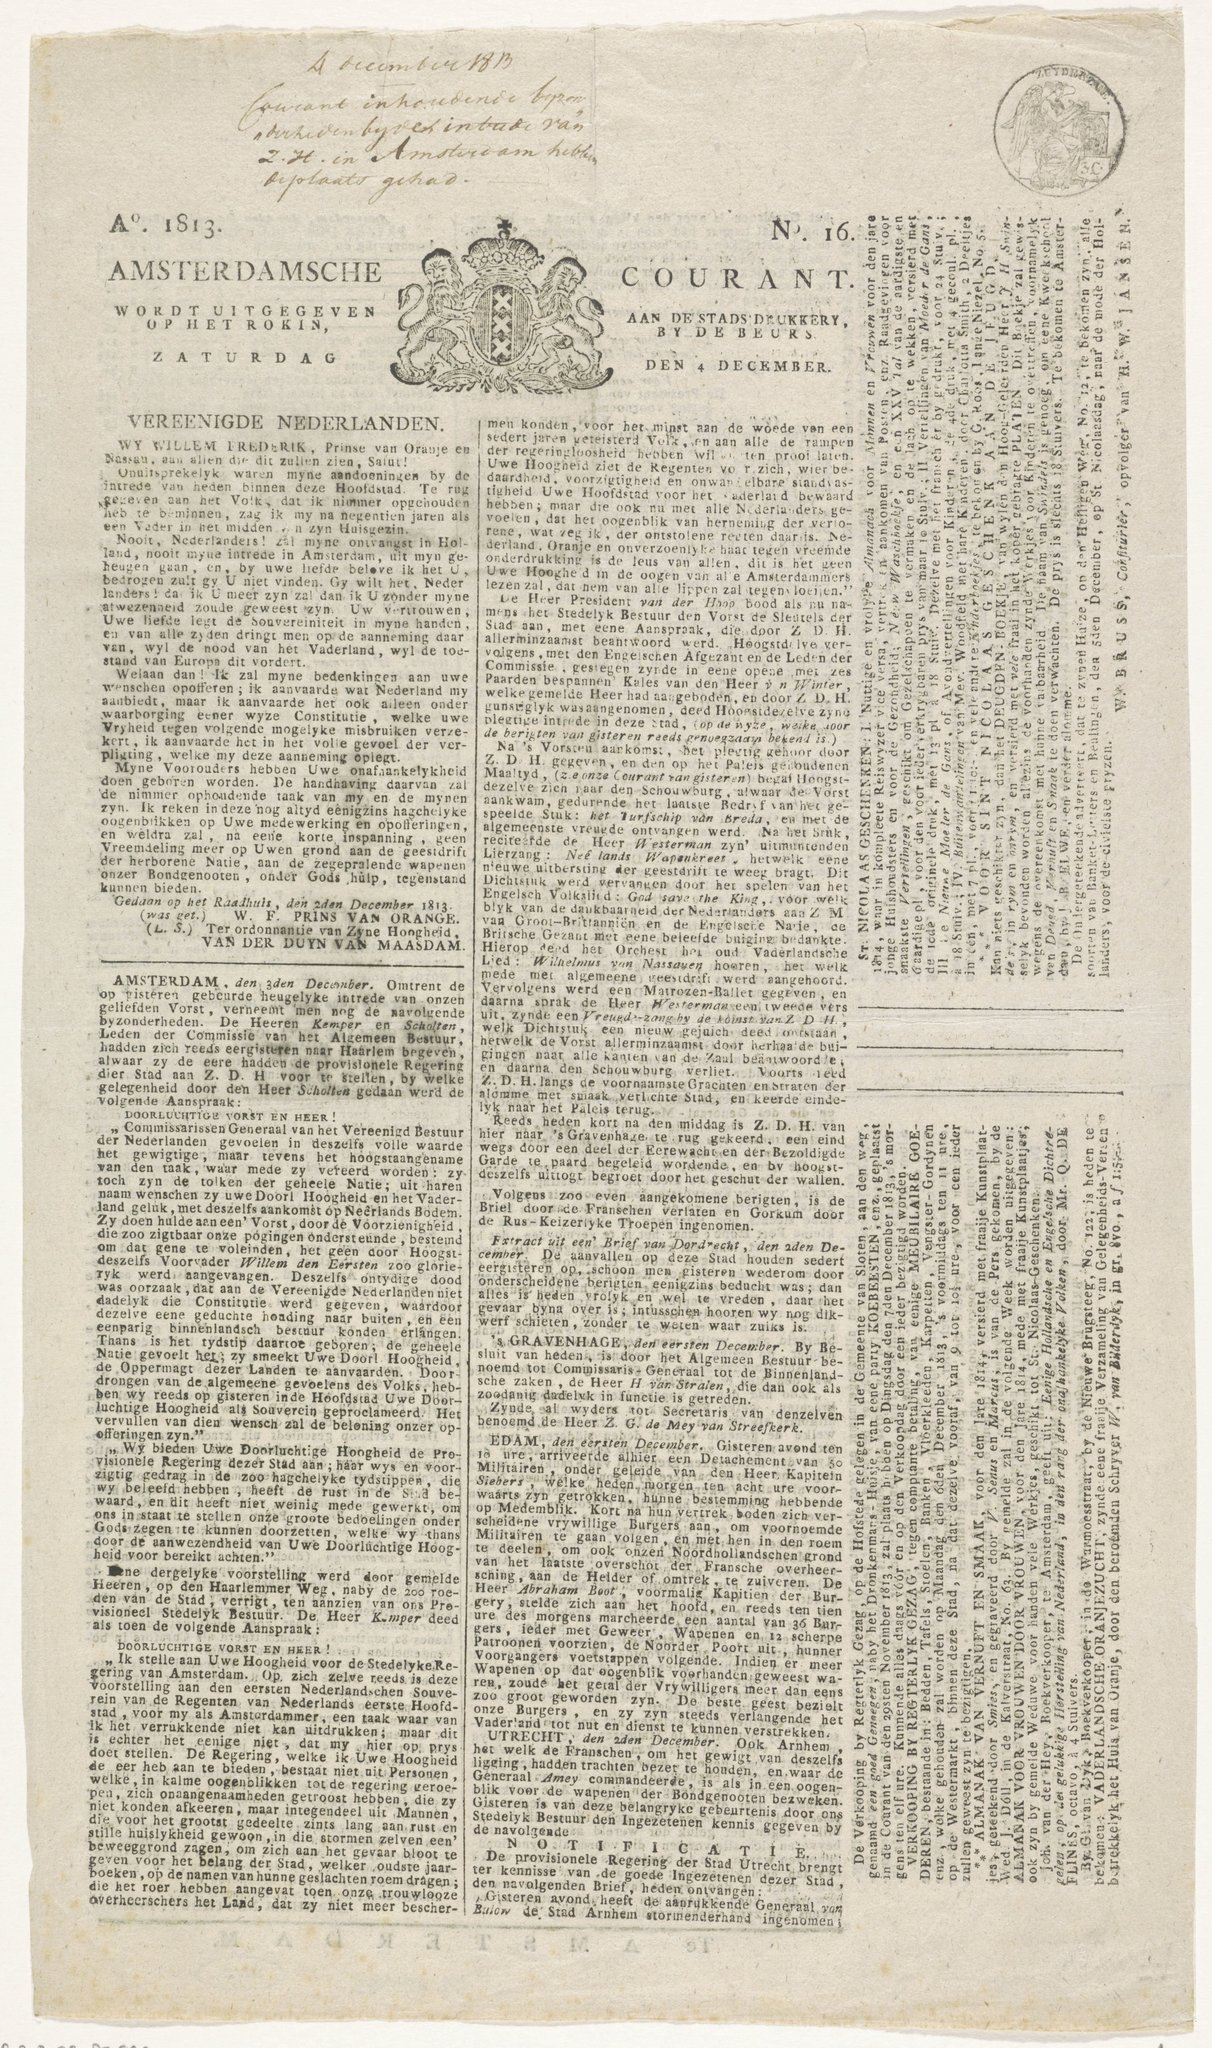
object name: text sheet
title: Amsterdamsche Courant van 4 december 1813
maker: Anonymous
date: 1813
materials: paper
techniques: letterpress printing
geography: amsterdam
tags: amsterdam, landing of william frederick i (1813)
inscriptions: collector's mark: Lugt 2228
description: Aflevering van de Amsterdamsche Courant van 4 december 1813 met het nieuws van de intrede van prins Willem Frederik als soeverein vorst, te Amsterdam op 2 december 1813. Blad bedrukt op beide zijden, op de voorzijde bovenaan het wapen van Amsterdam en rechtsboven een ronde stempel 'Zuyderzee 3 C.'.